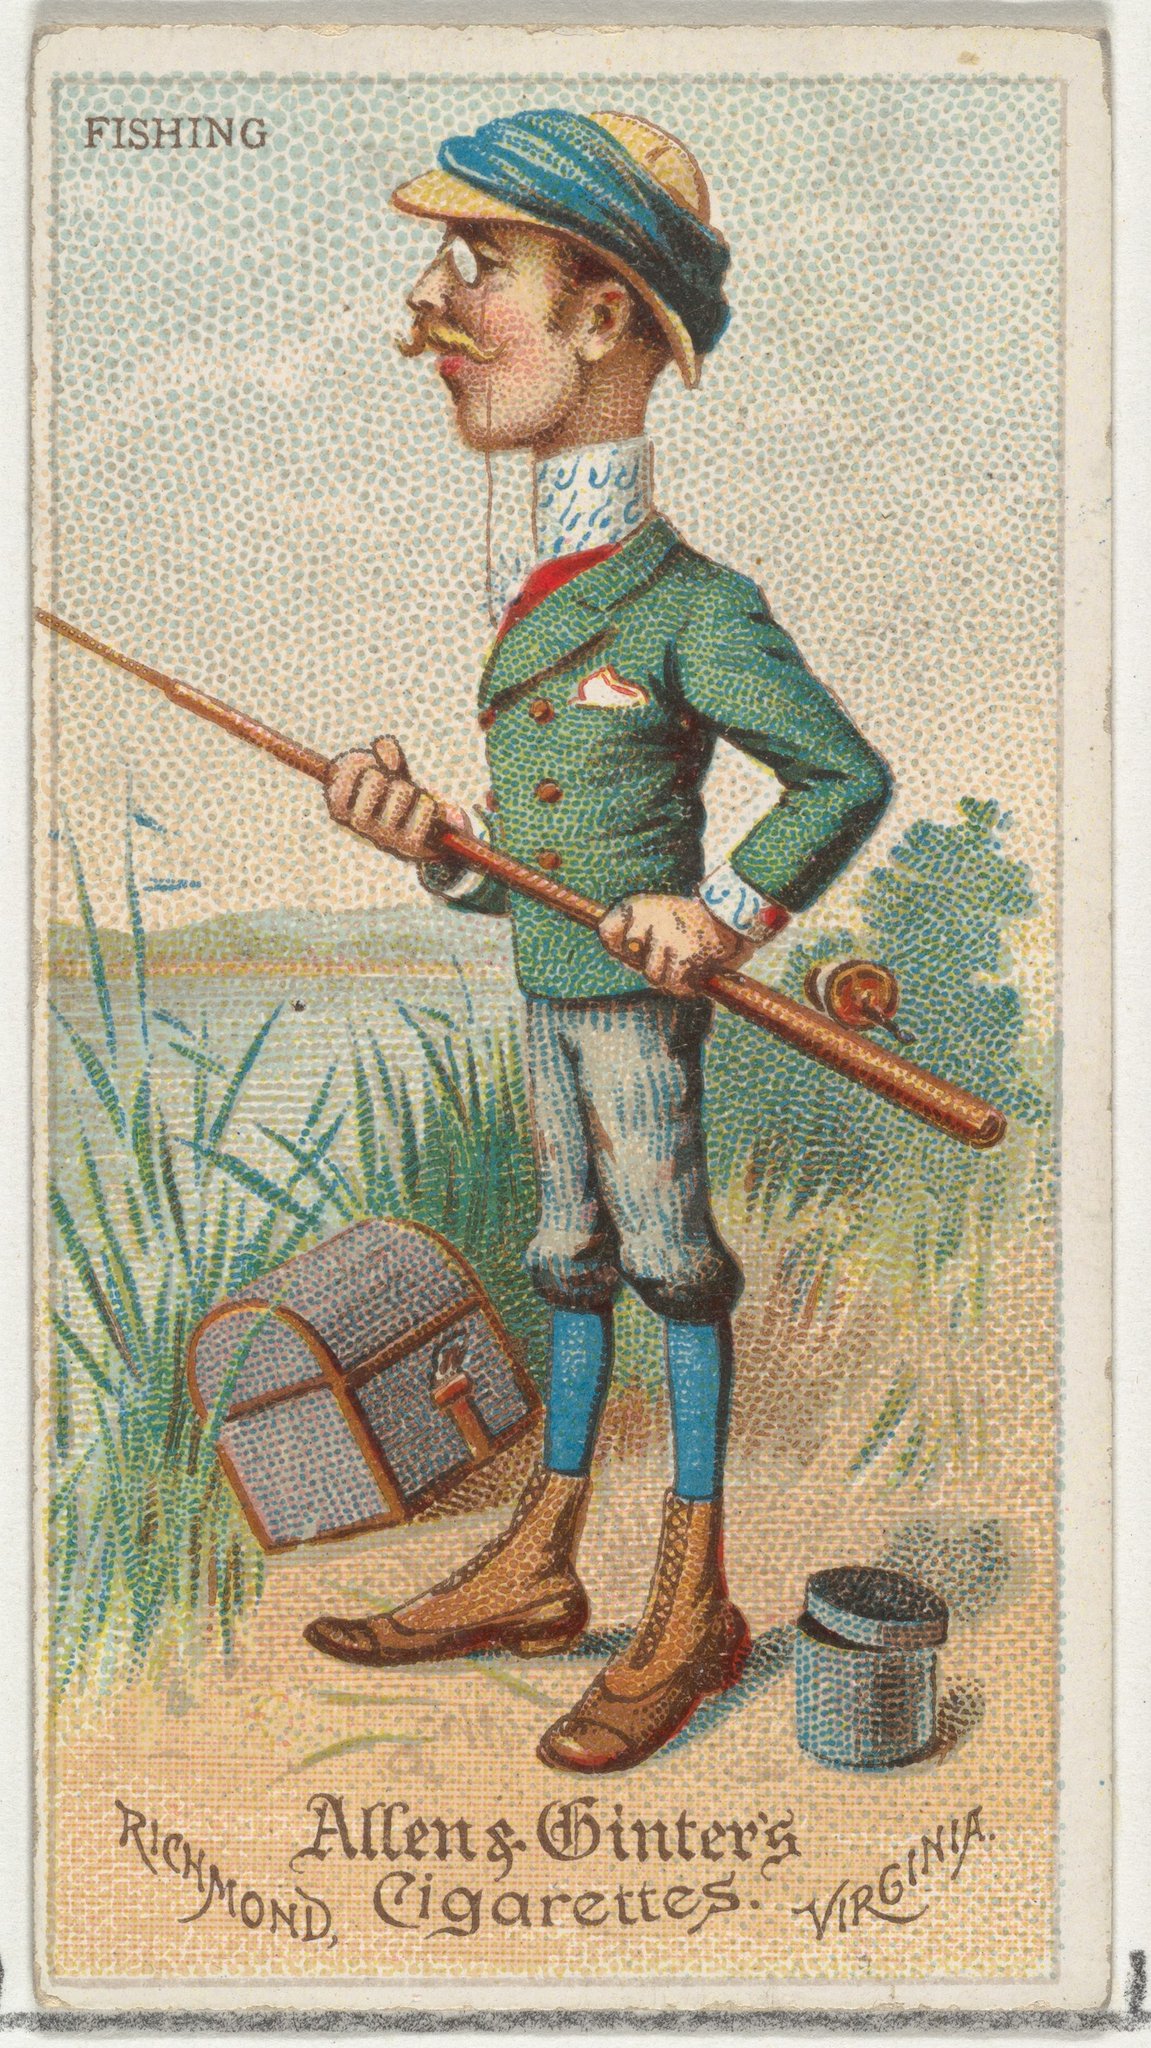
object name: print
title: Fishing, from World's Dudes series (N31) for Allen & Ginter Cigarettes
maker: allen & ginter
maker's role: publisher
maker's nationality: american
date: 1888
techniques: color lithograph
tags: men,fishing